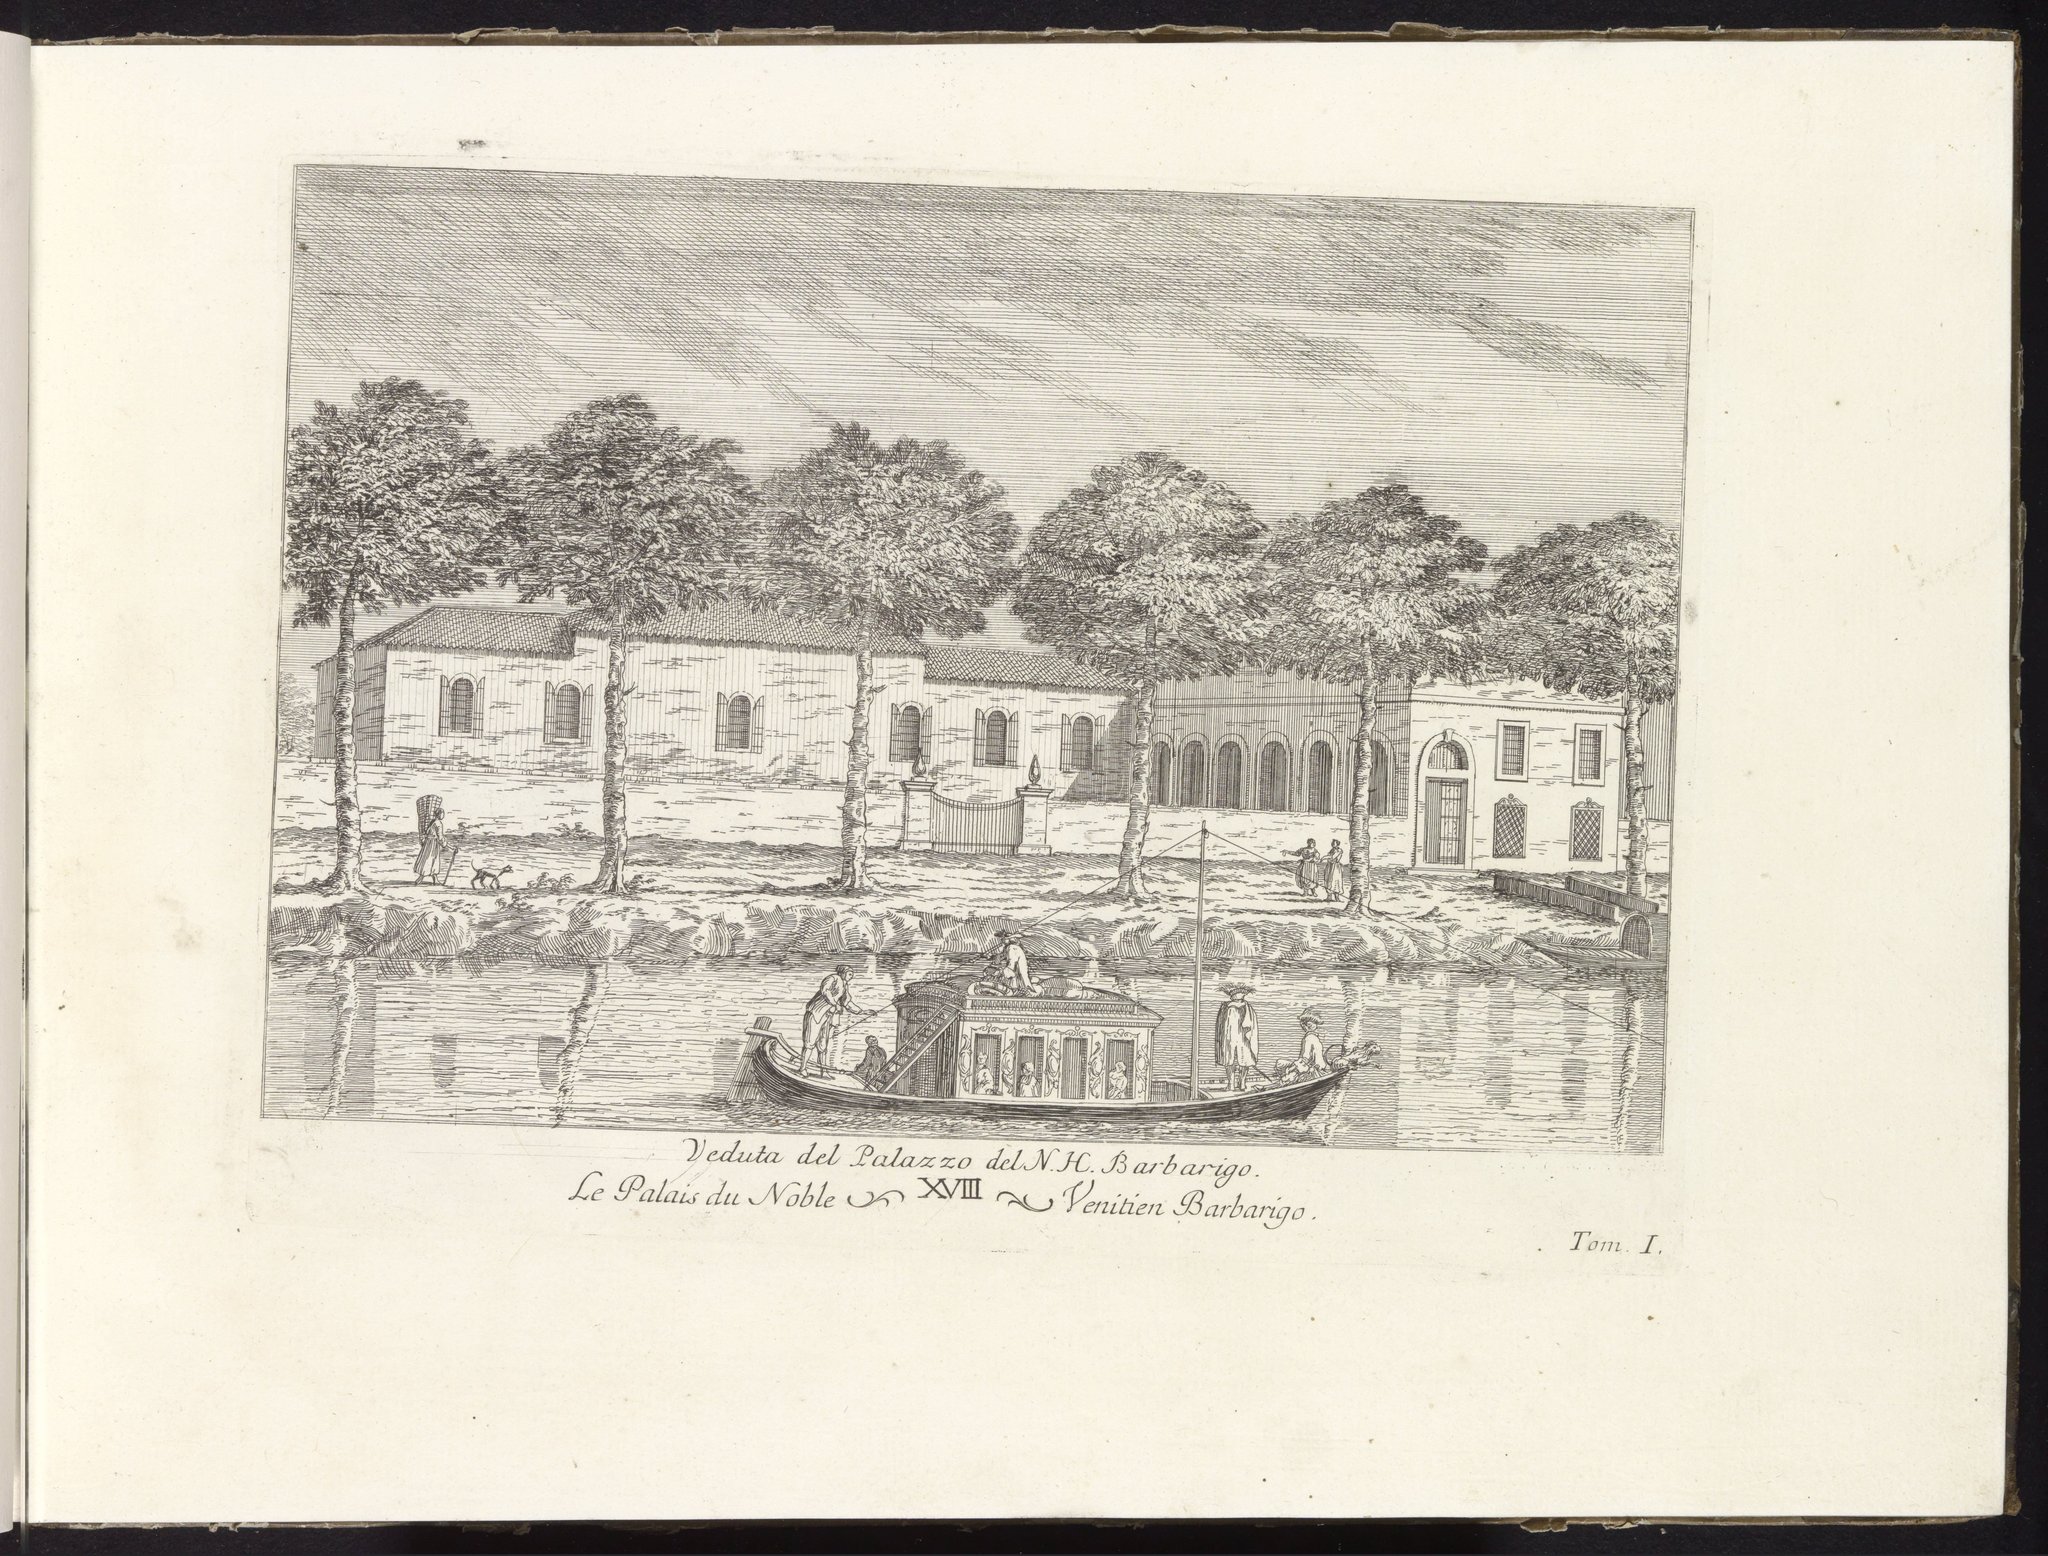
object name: print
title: Gezichten op de rivier de Brenta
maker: giovanni francesco costa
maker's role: draughtsman, painter, print maker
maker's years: -1773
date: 1750-1760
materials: paper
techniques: etching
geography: italy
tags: river, tow-boat, towing-barge, hôtel, i.e. small palace in city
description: Gezicht op het Palazzo del N. H. Barbarigo aan de rivier de Brenta. Op het water vaart een trekschuit. Genummerd midden onder: XVIII en rechtsonder: Tom: I. Deze prent maakt deel uit van een album.